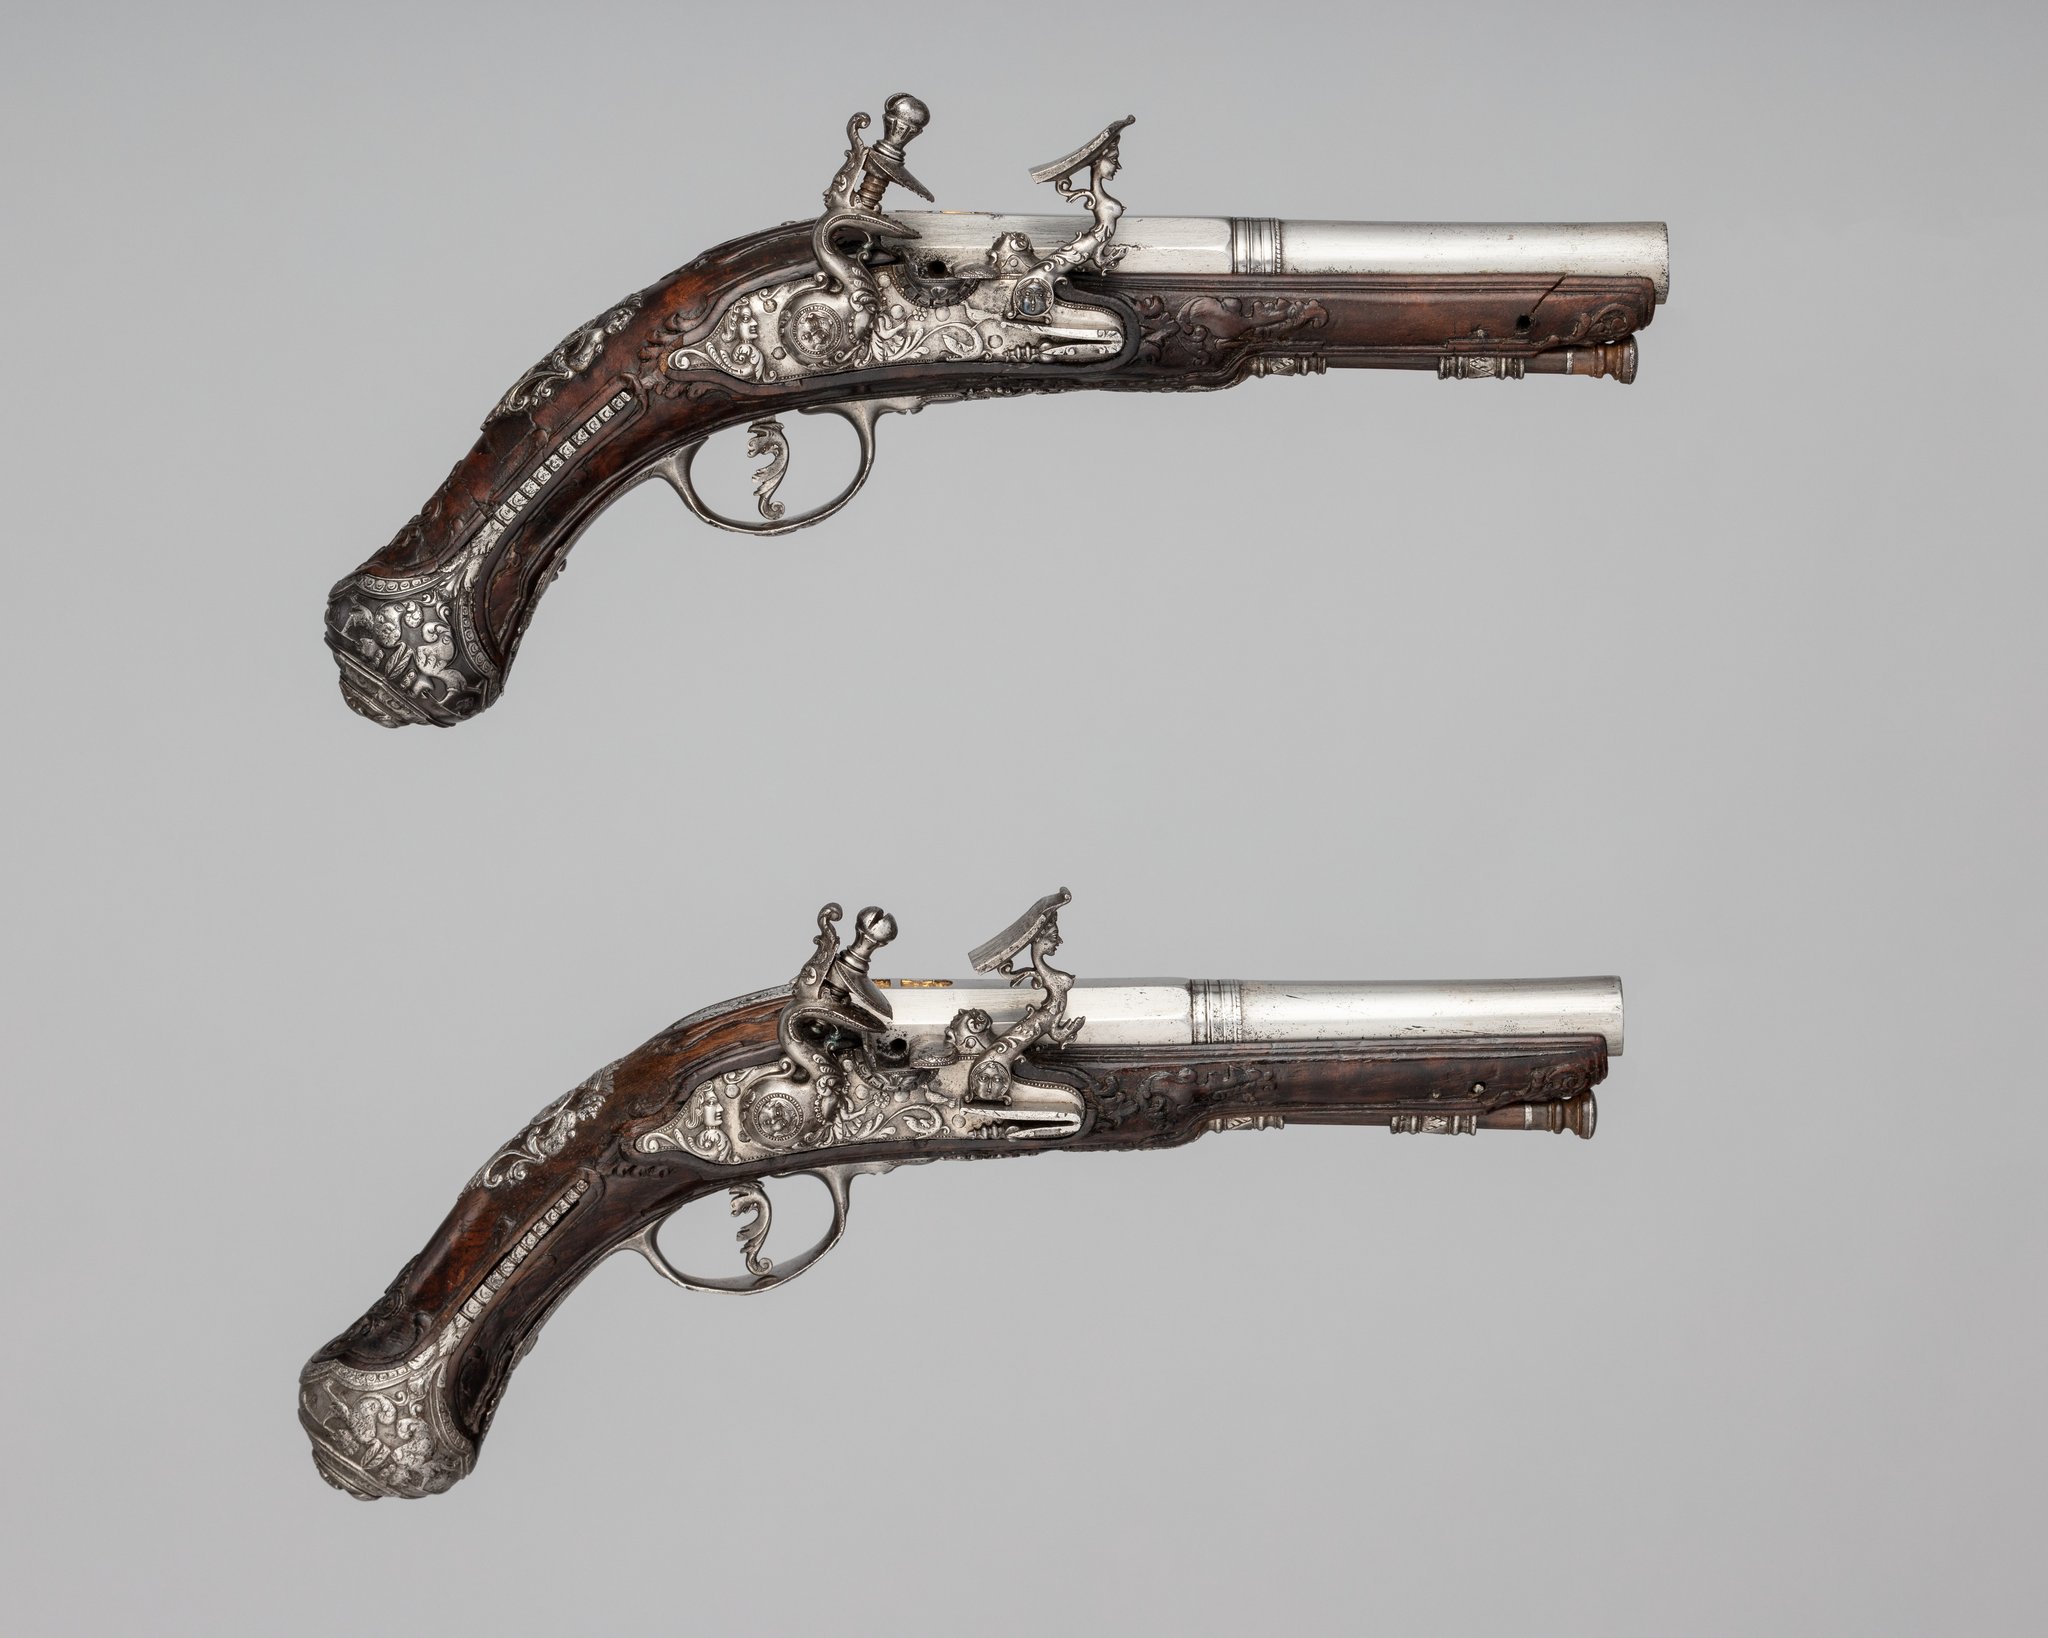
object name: pair of snaphaunce pistol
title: Pair of Snaphaunce Pistols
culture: italian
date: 1725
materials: gold, steel, wood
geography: italy